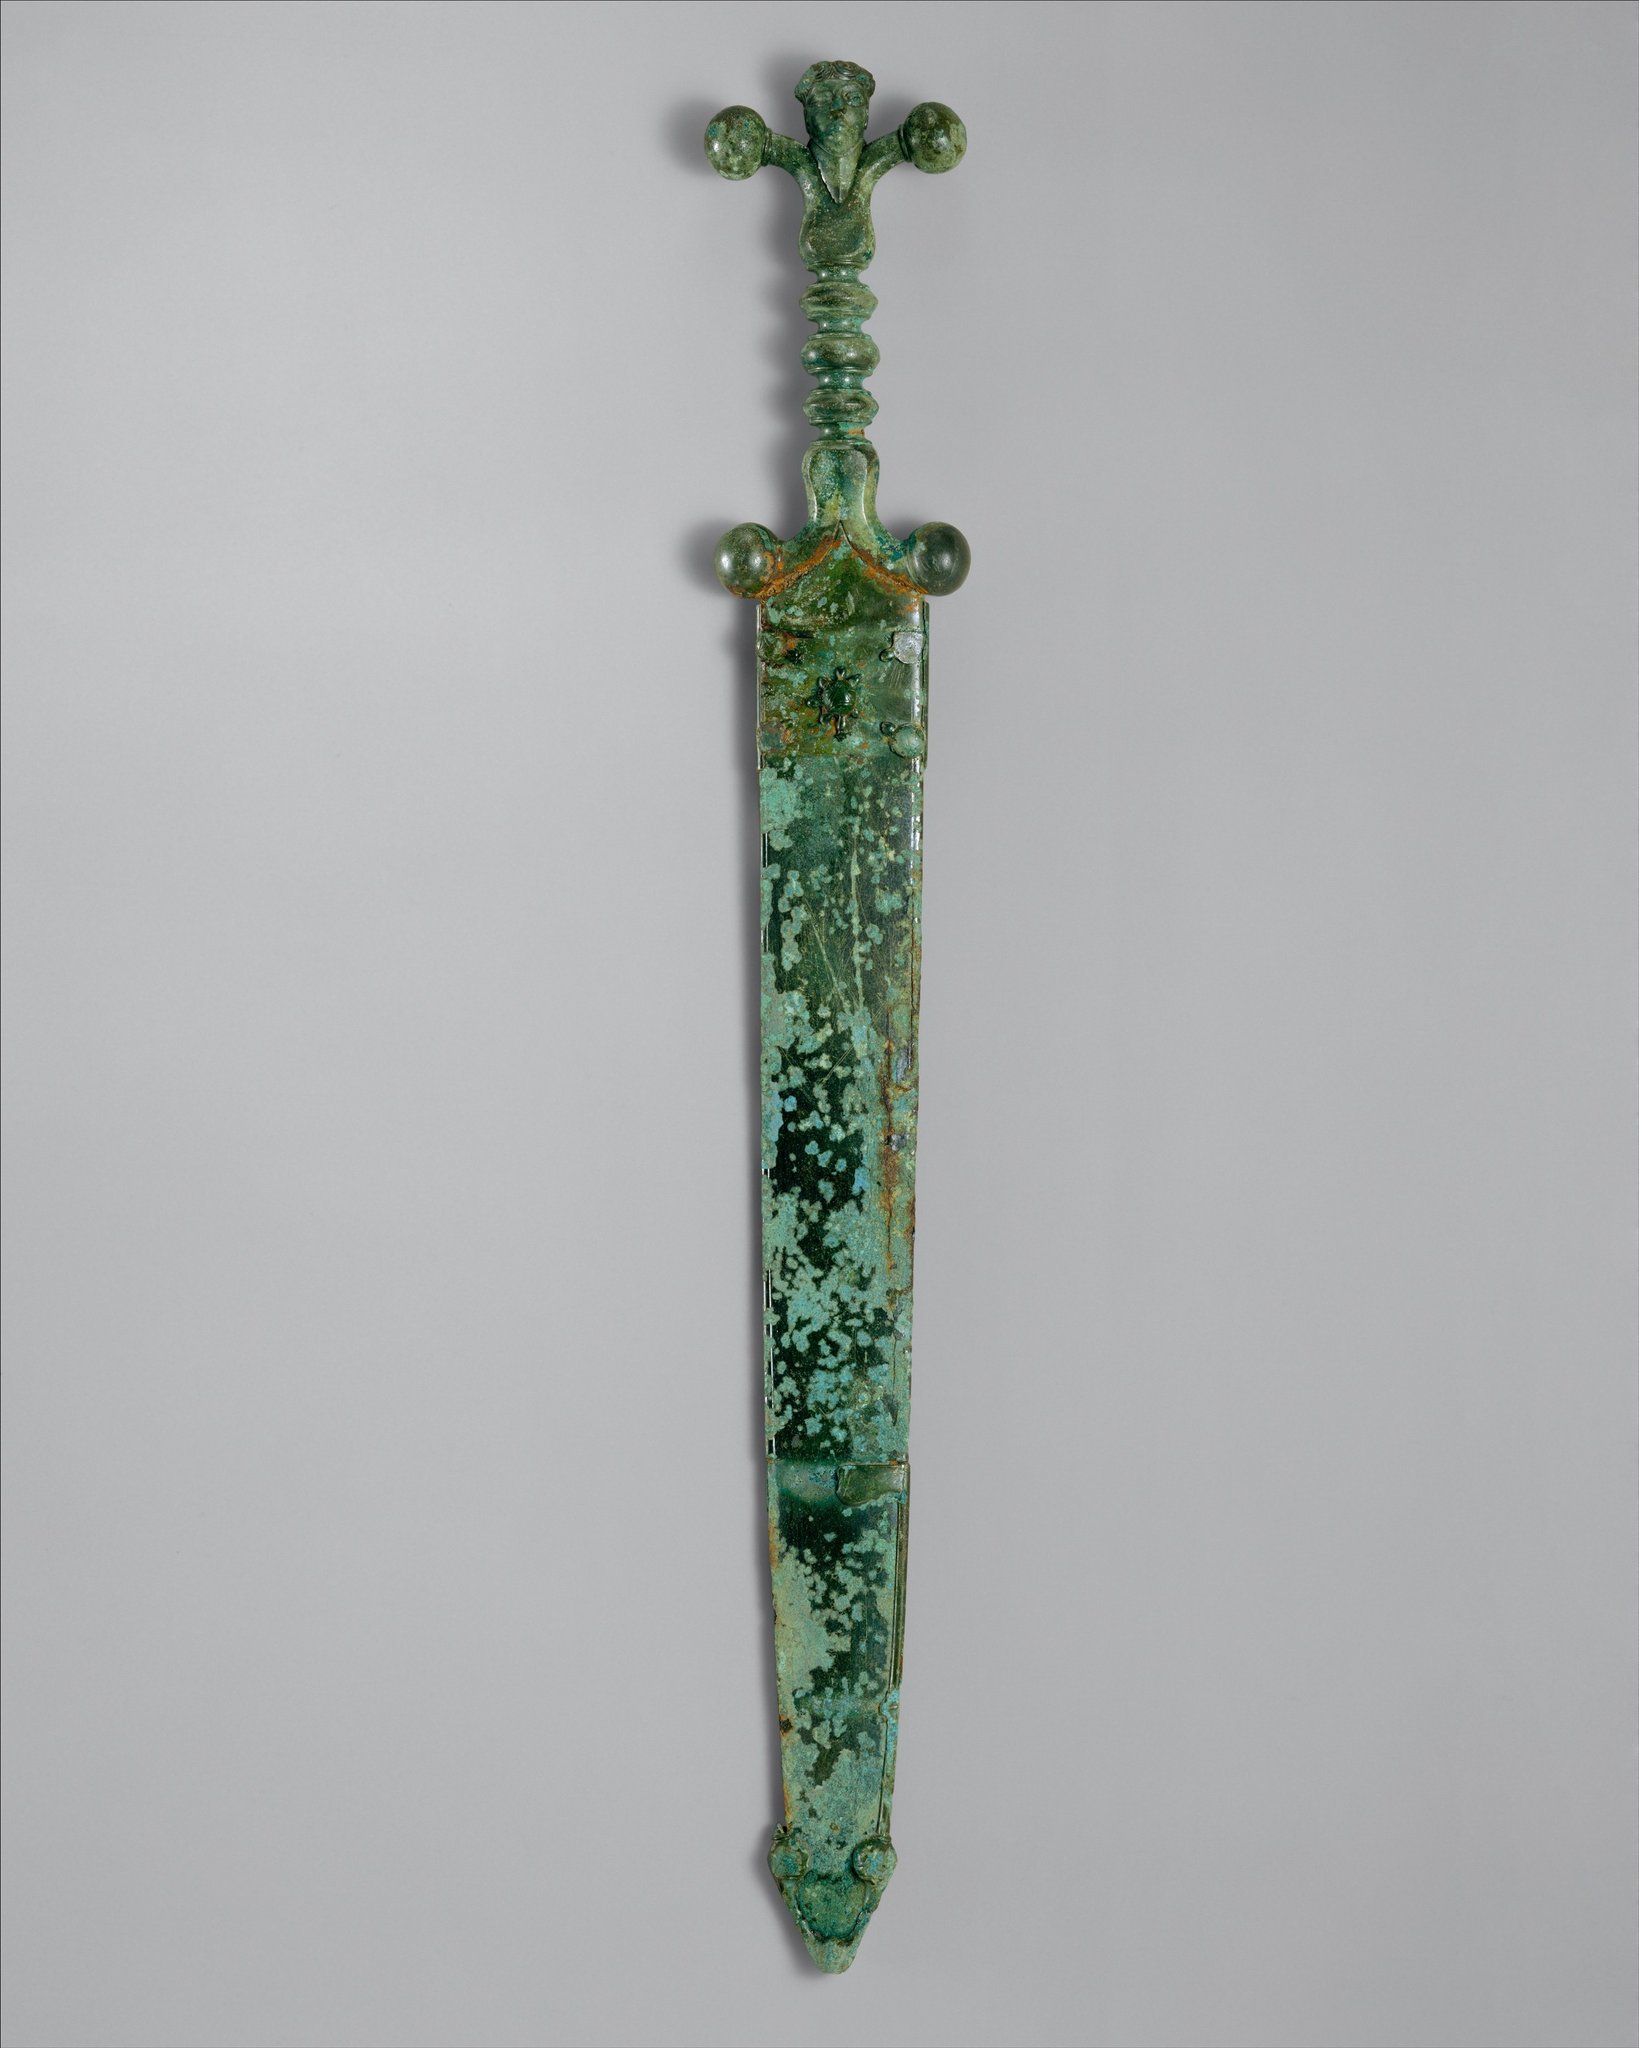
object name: sword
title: Sword and Scabbard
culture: celtic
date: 60 BCE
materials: copper alloy, iron